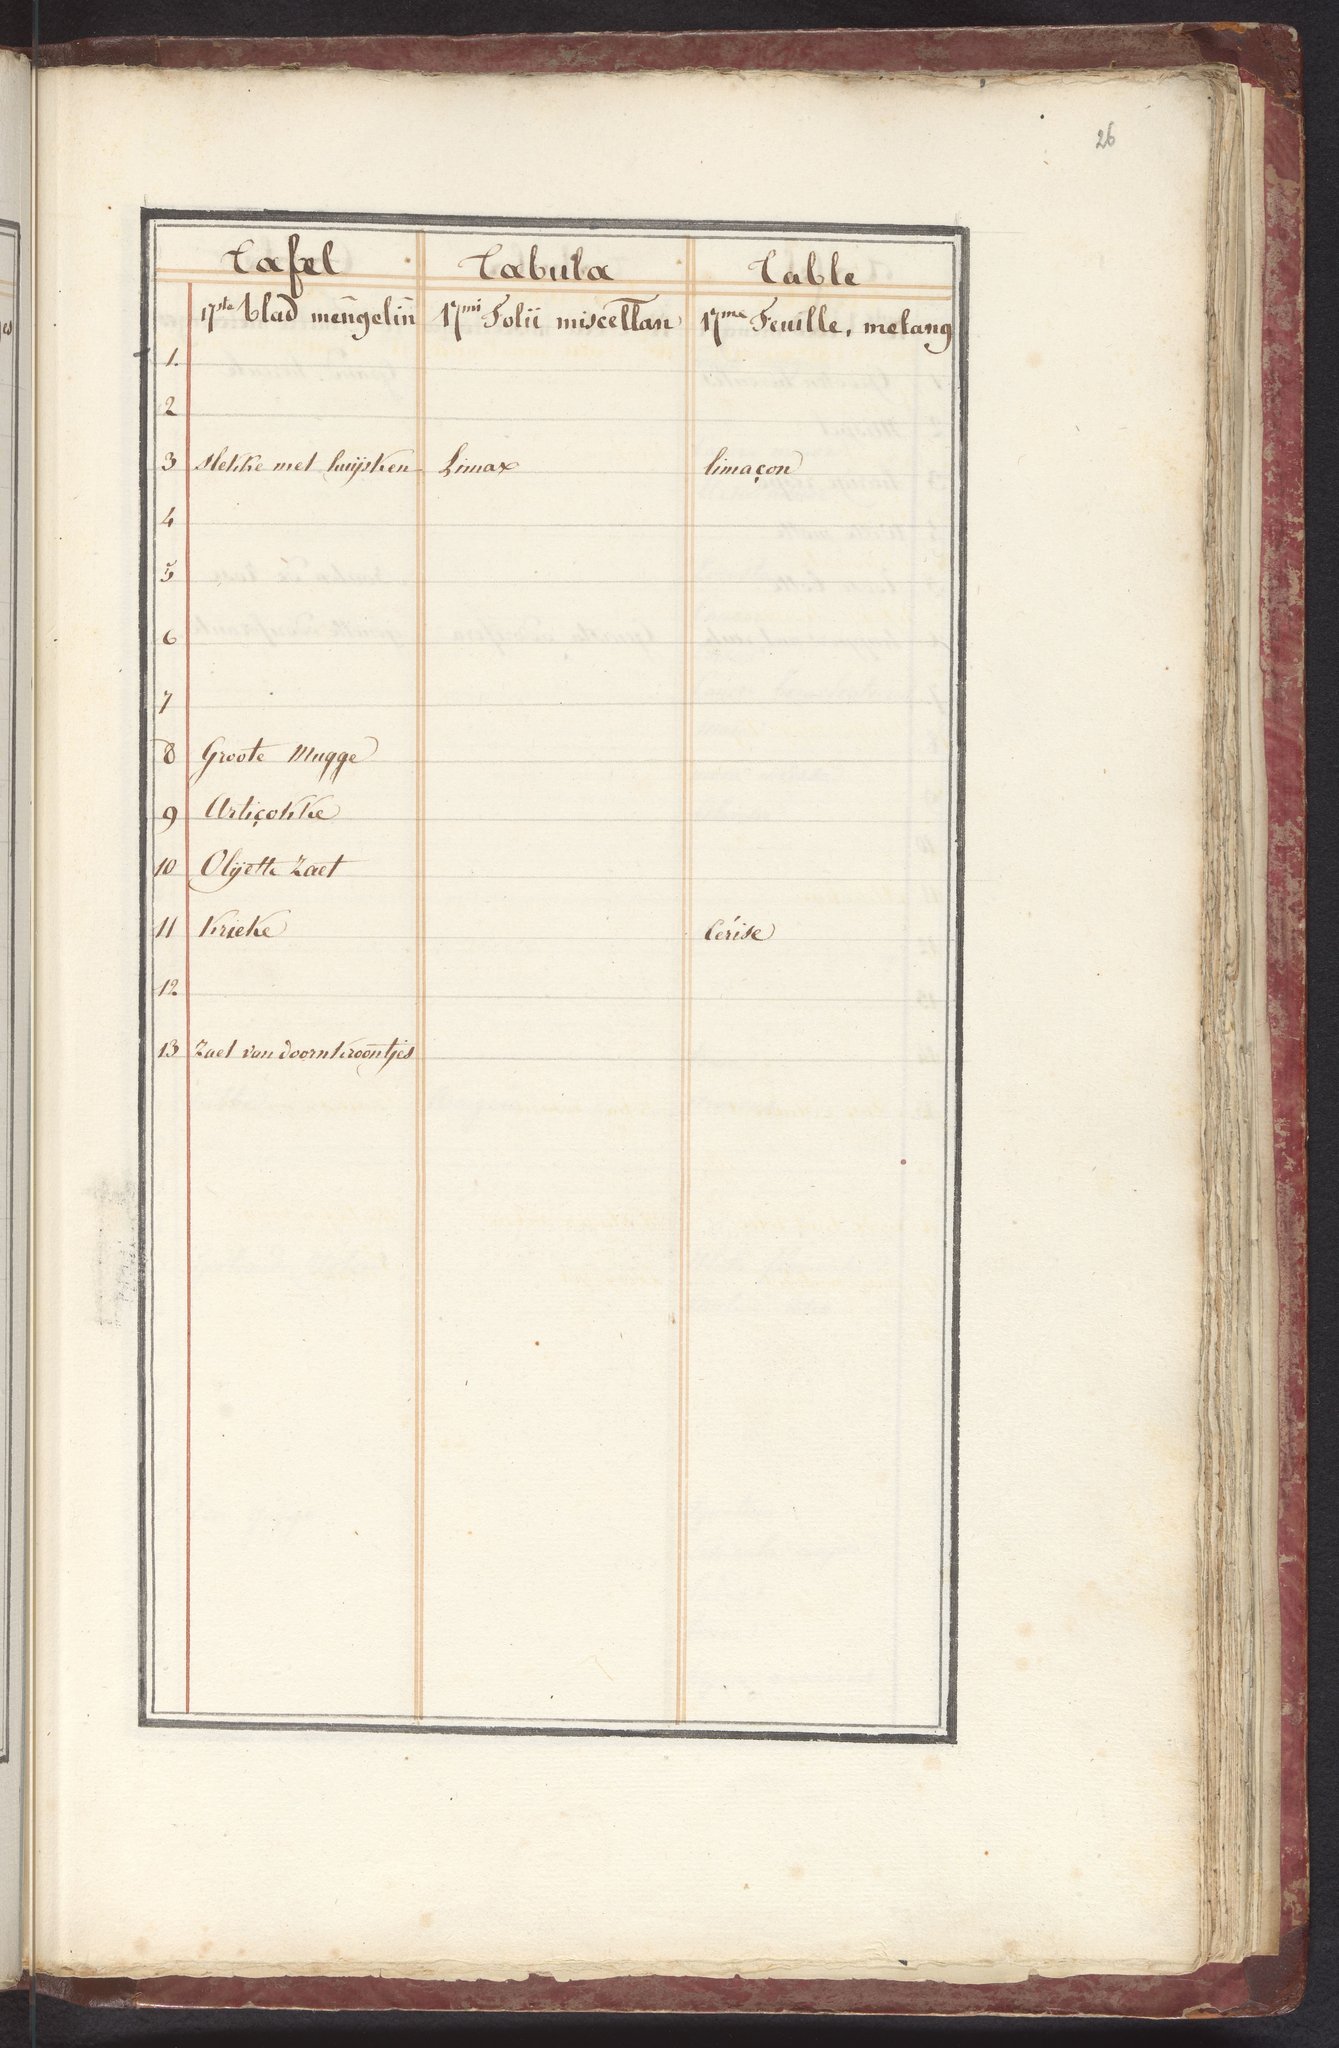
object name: manuscript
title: Lijst van dieren en planten in het zeventiende ensemble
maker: joseph van huerne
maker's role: kunstliefhebber, mecenas, verzamelaar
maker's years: 1752-1844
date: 1809-1814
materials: ink, paper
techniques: handwriting, pen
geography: bruges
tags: handwriting, written text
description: Schema met een lijst in drie kolommen van de dieren en planten afgebeeld in het zeventiende ensemble, nummers 1-13. Onderdeel van het zevende album met tekeningen van reptielen, amfibieën en natuurhistorische ensembles. Het zevende van twaalf albums met aquarellen van dieren, vogels en planten bekend rond 1600, gemaakt in opdracht van keizer Rudolf II. Met toelichting in Nederlands, Latijn en Frans.